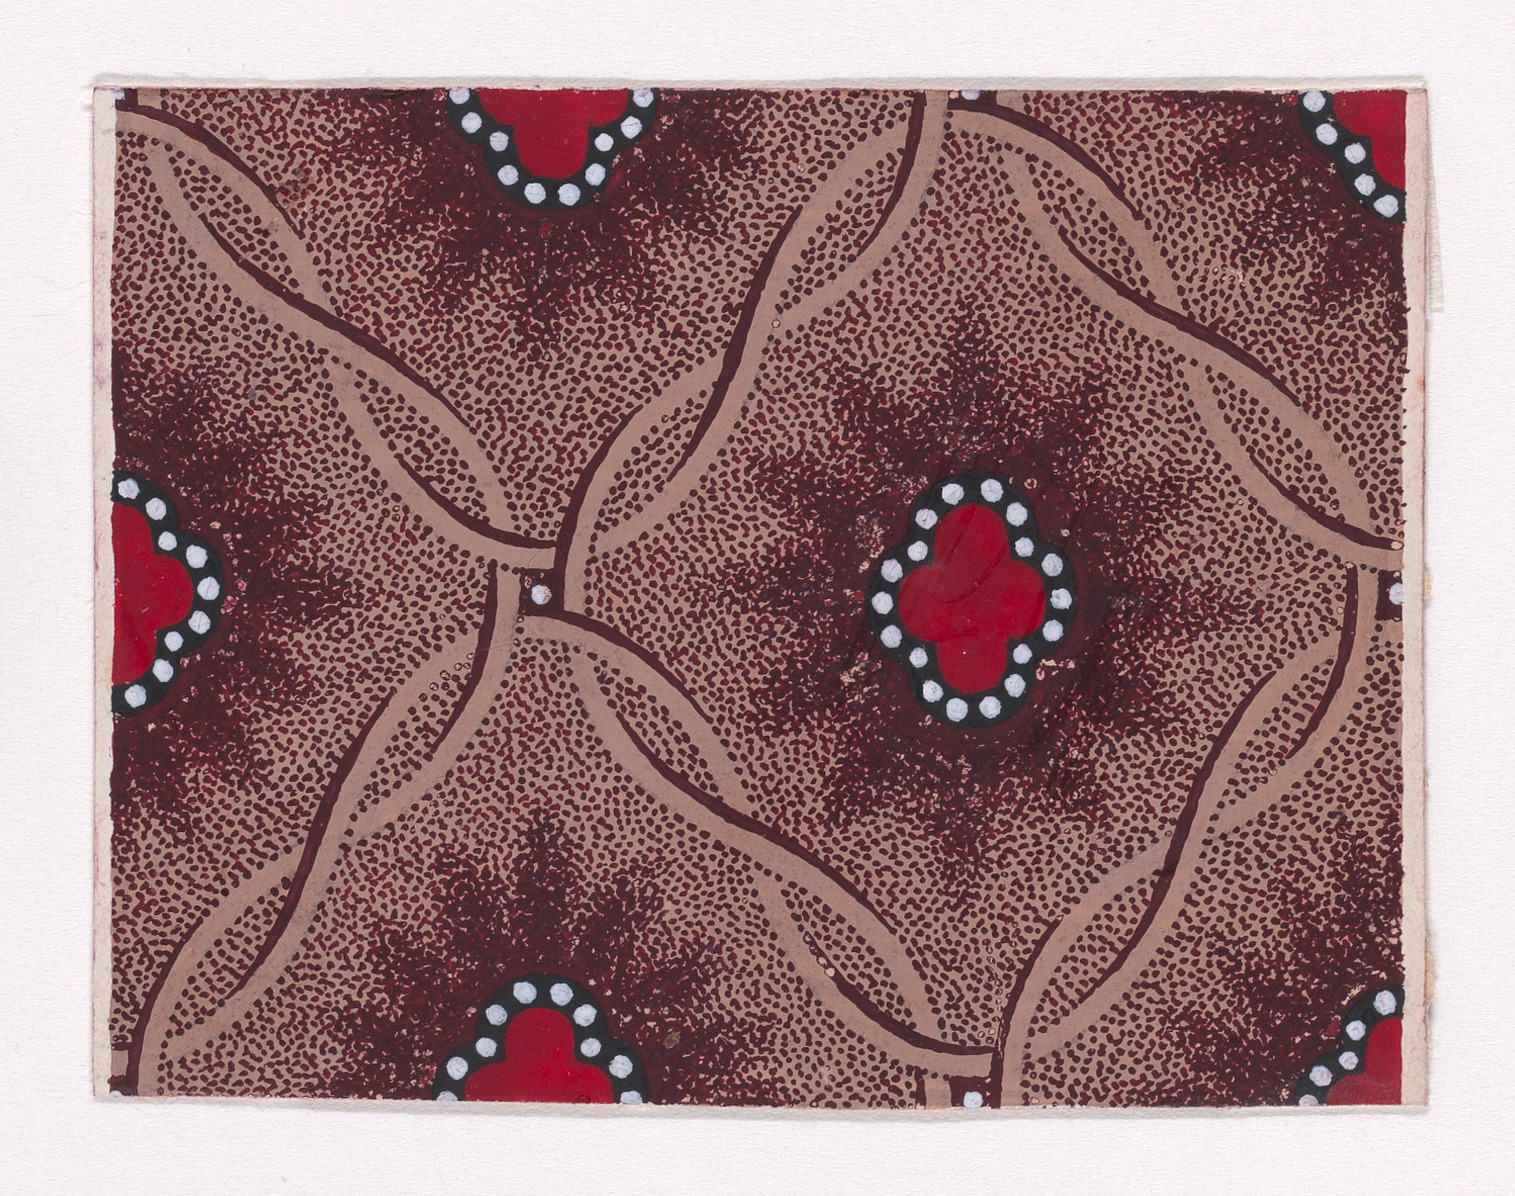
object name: drawing ornament architecture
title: Textile Design with Alternating Quatrefoils Bordered with Pearls and Framed by Interlacing Ribbons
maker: anonymous, alsatian, 19th century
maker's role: artist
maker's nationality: alsatian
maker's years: 1800-1900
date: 1840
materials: gouache